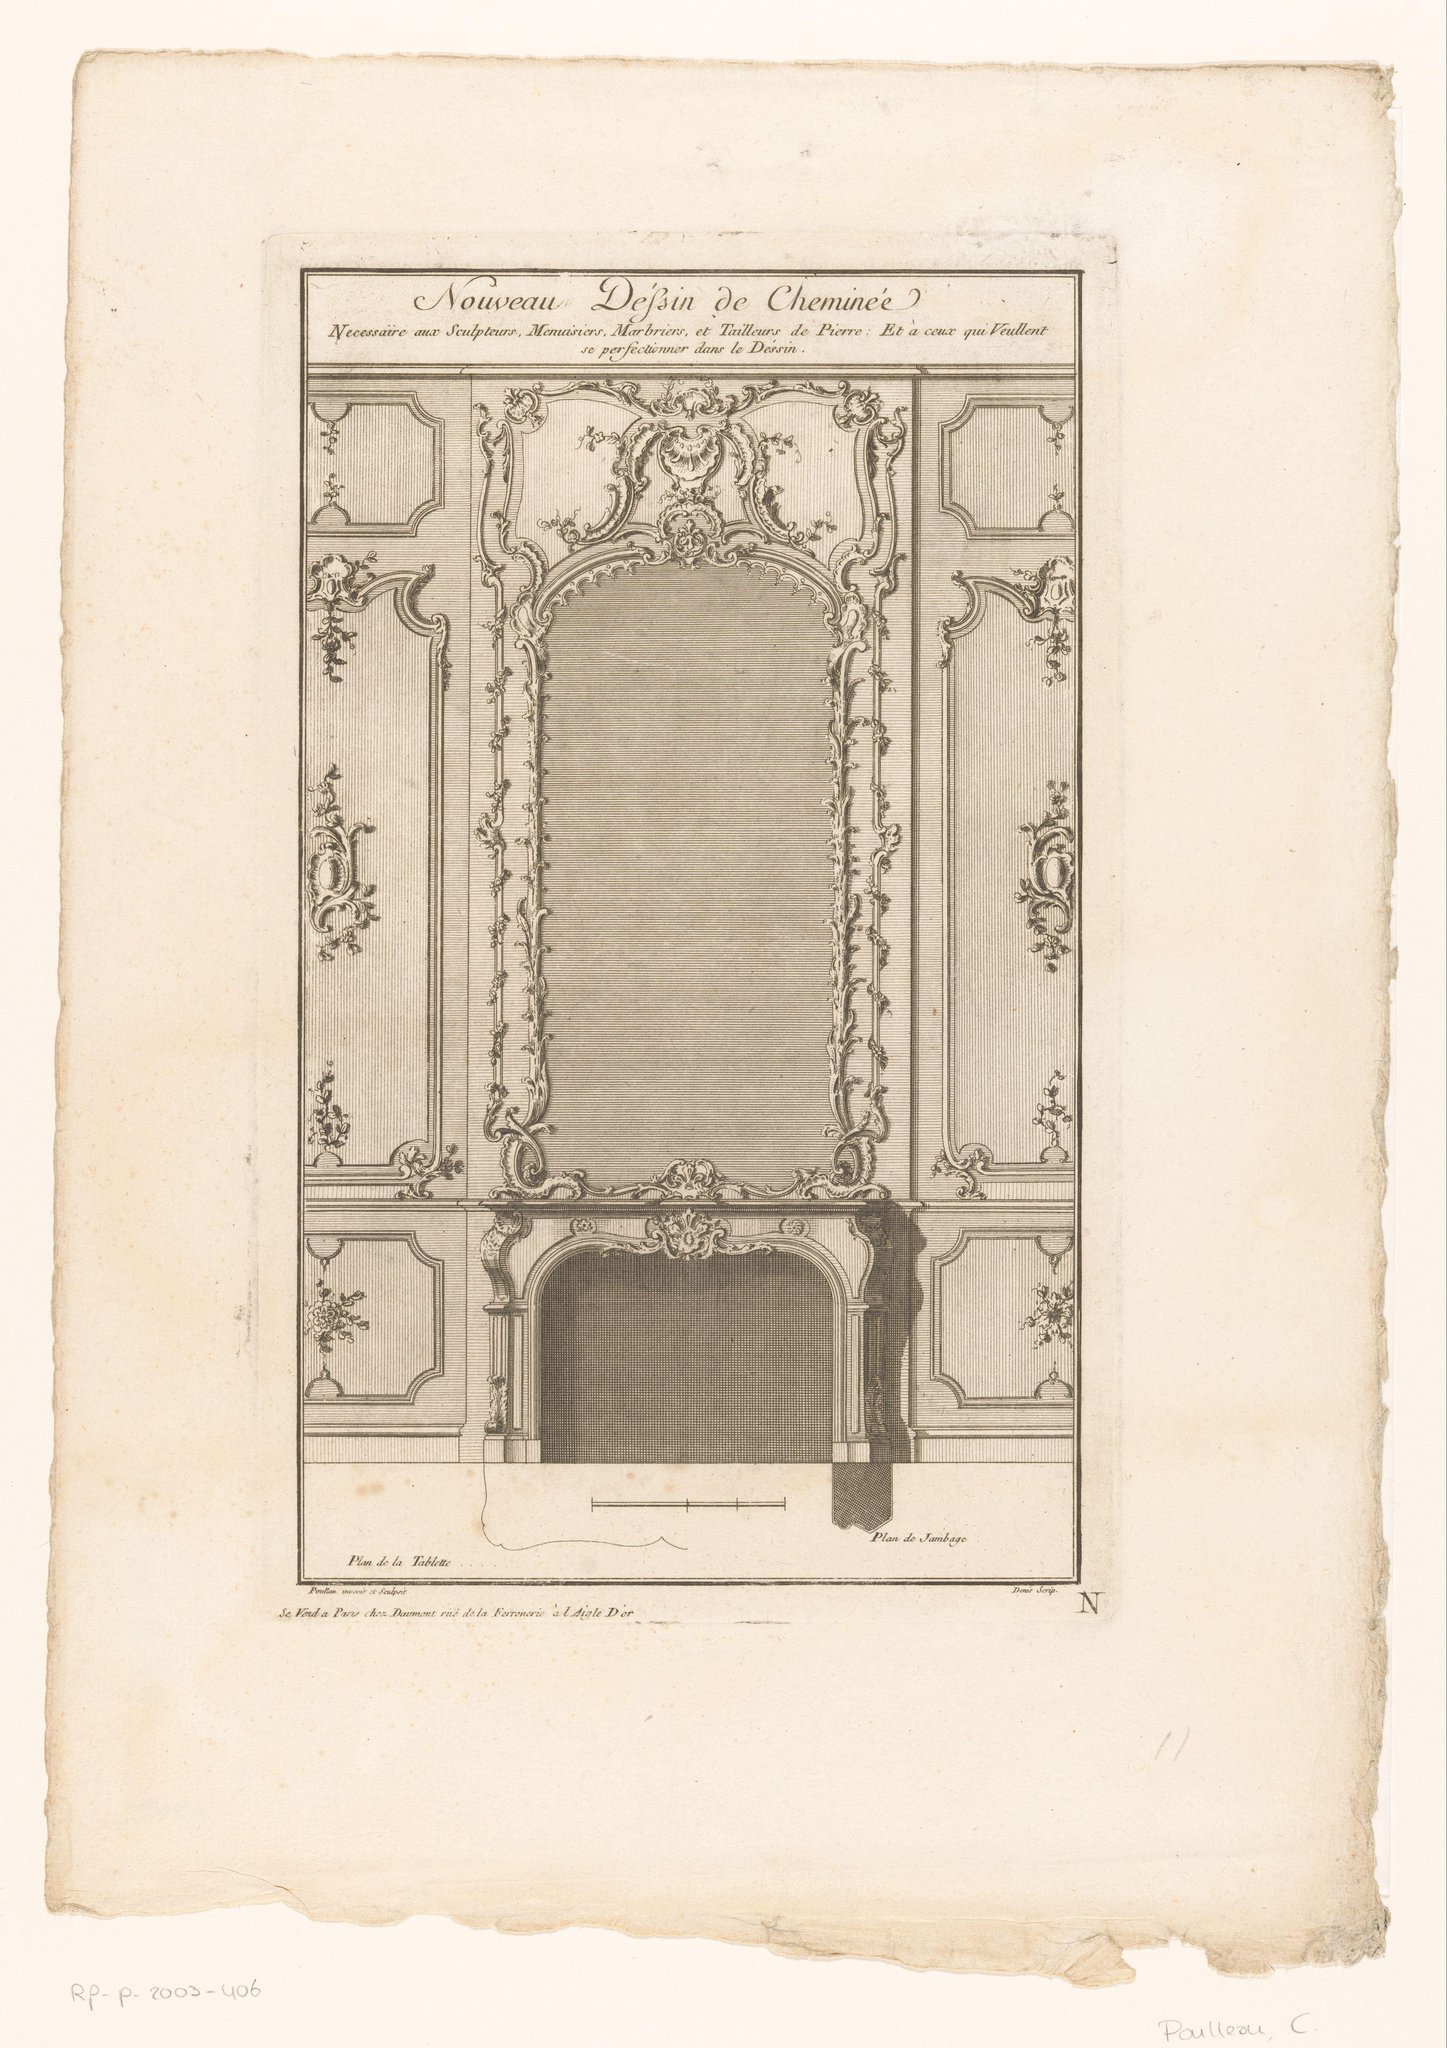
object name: ornament print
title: N Nouveau Dessin de Cheminée. Necessaire aux Menuisiers Sculpteurs et Tailleurs de Pierre Et a ceux qui Veullent se perfectionner dans le Dessin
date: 1759-1775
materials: paper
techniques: etching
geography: paris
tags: rocaille ornament, open hearth, fire-place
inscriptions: collector's mark: Lugt 2228, collector's mark: Lugt 2760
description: Prent is onderdeel van een serie van vier. Prenten RP-P-2003-404 t/m 407 zijn aan elkaar gebonden.